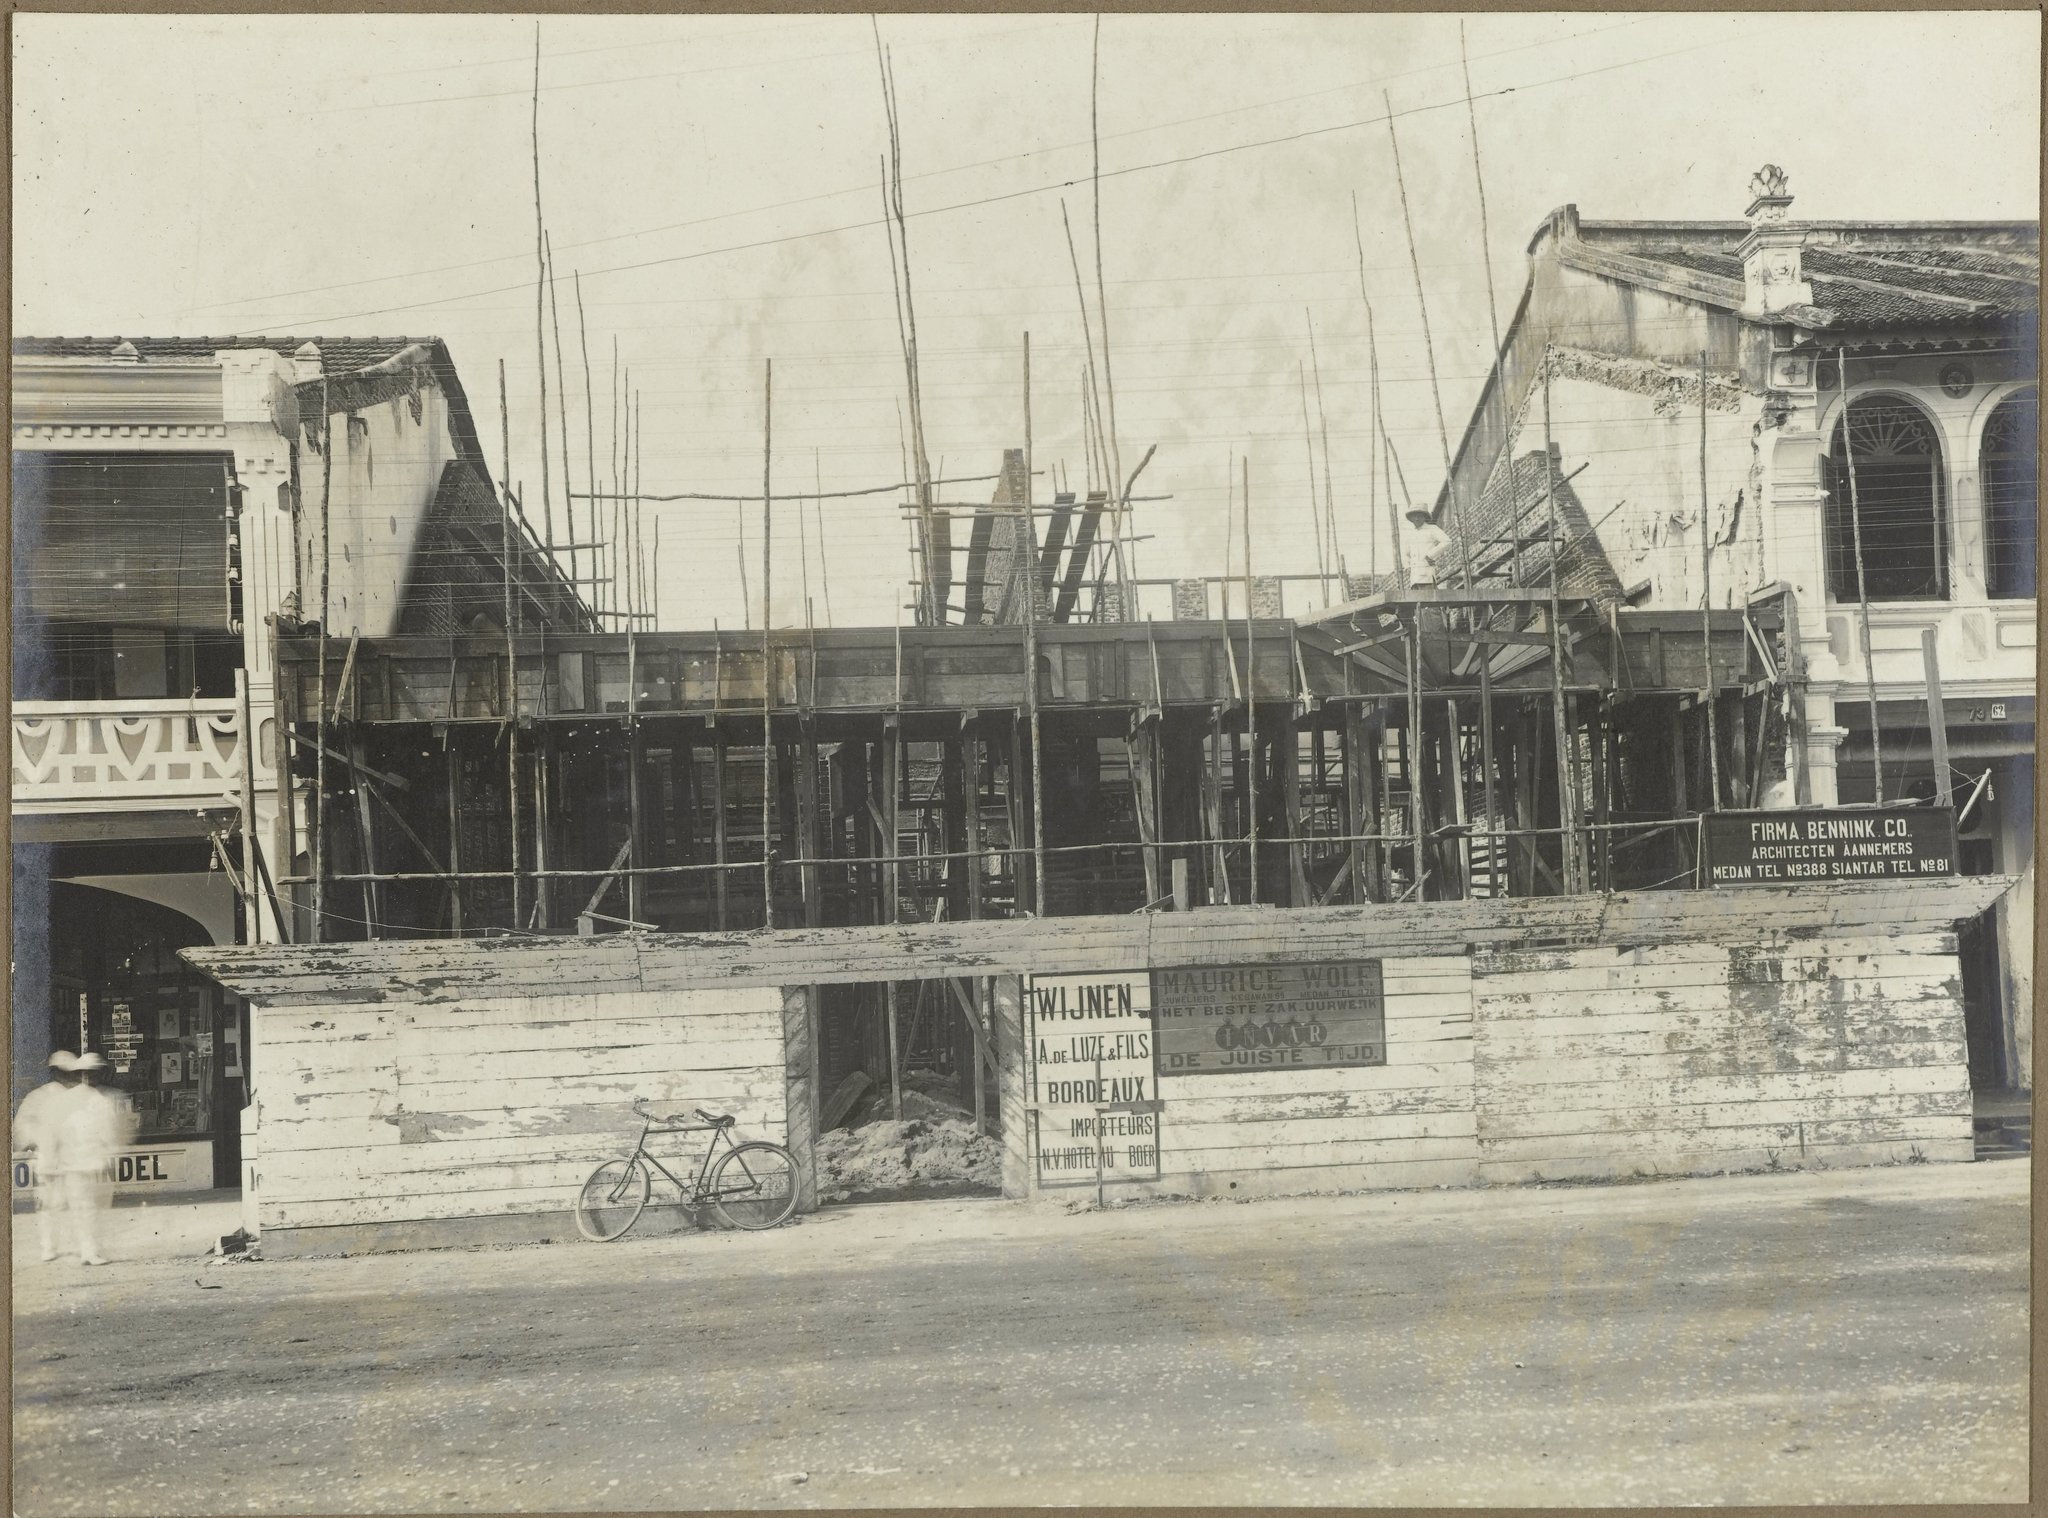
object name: photograph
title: Bouwplaats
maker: Anonymous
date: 1914-1919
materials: photographic support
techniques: gelatin silver print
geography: medan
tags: making the overground structures (~ building activities), representation of real building (either existing or having existed), architecture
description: De bouwplaats van een pand in een blok aan een straat, waarschijnlijk te Medan. Op de schutting staat een bord van de uitvoerder: Firma Bennink Co. Architecten Aannemers. Foto in het fotoalbum van het Nederlandse architectenbureau en aannemersbedrijf Bennink en Riphagen te Medan in de jaren ca. 1914-1919.